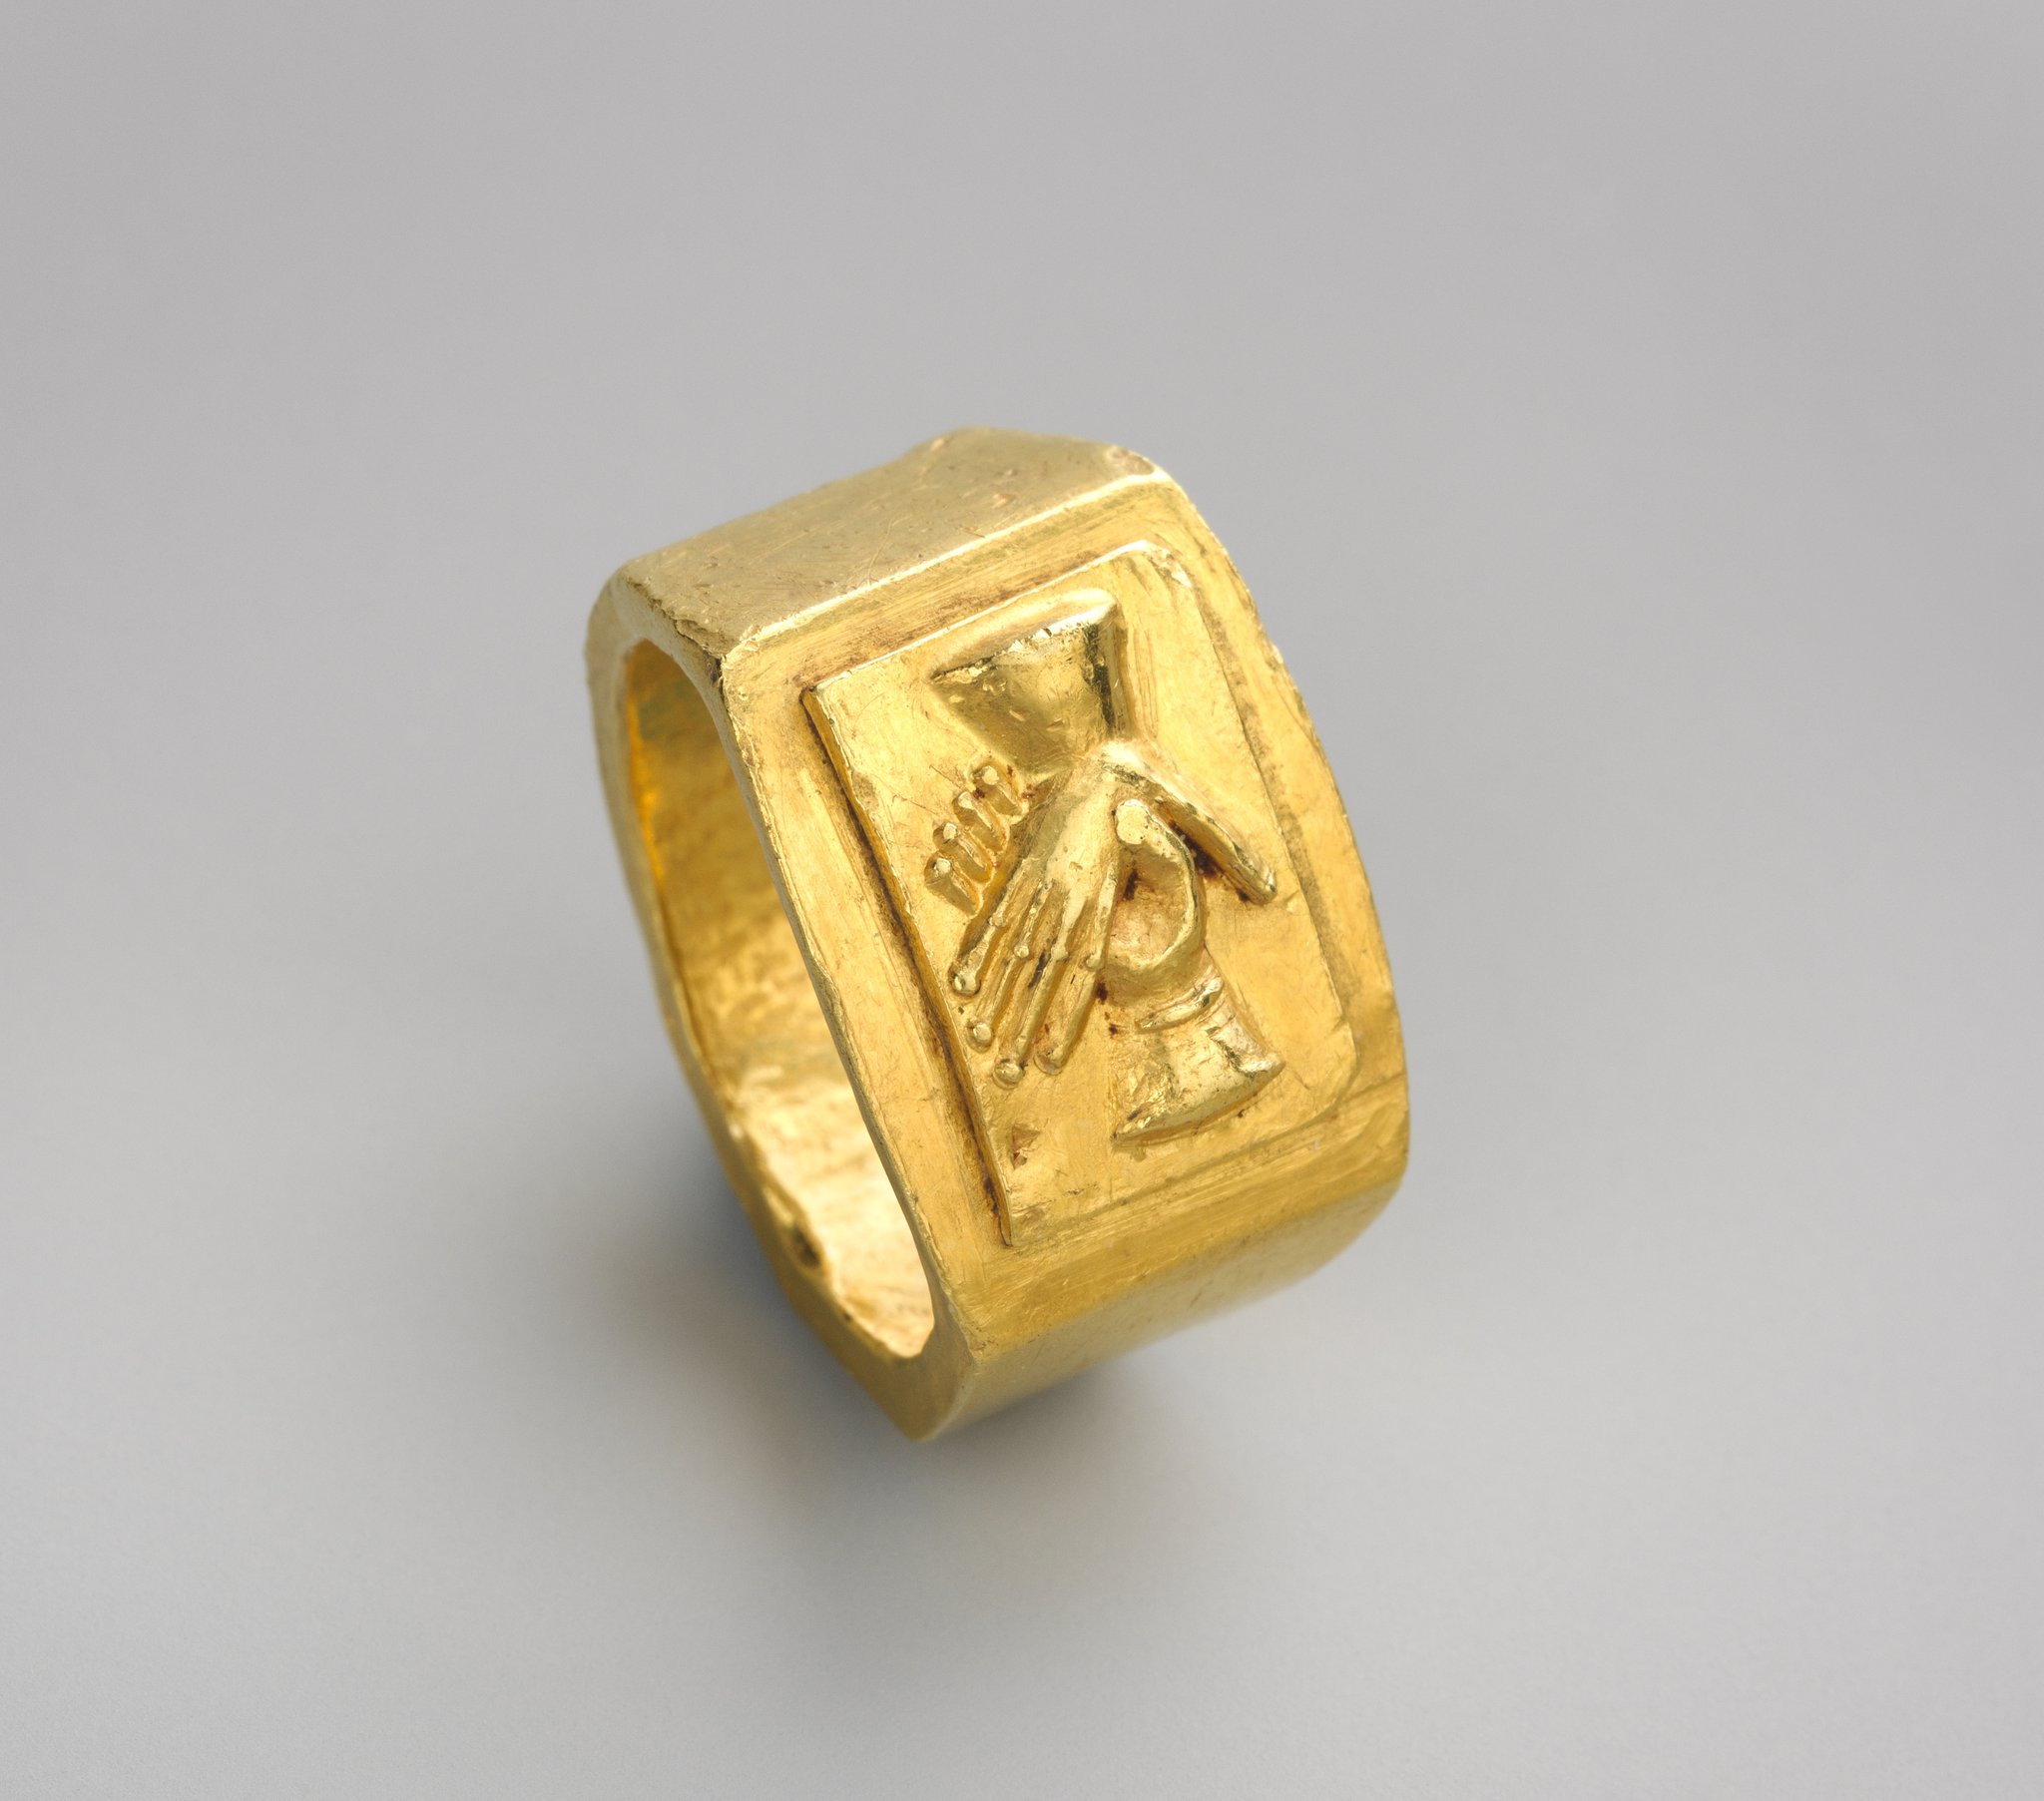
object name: ring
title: Gold finger ring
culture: roman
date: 201-300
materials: gold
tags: hands